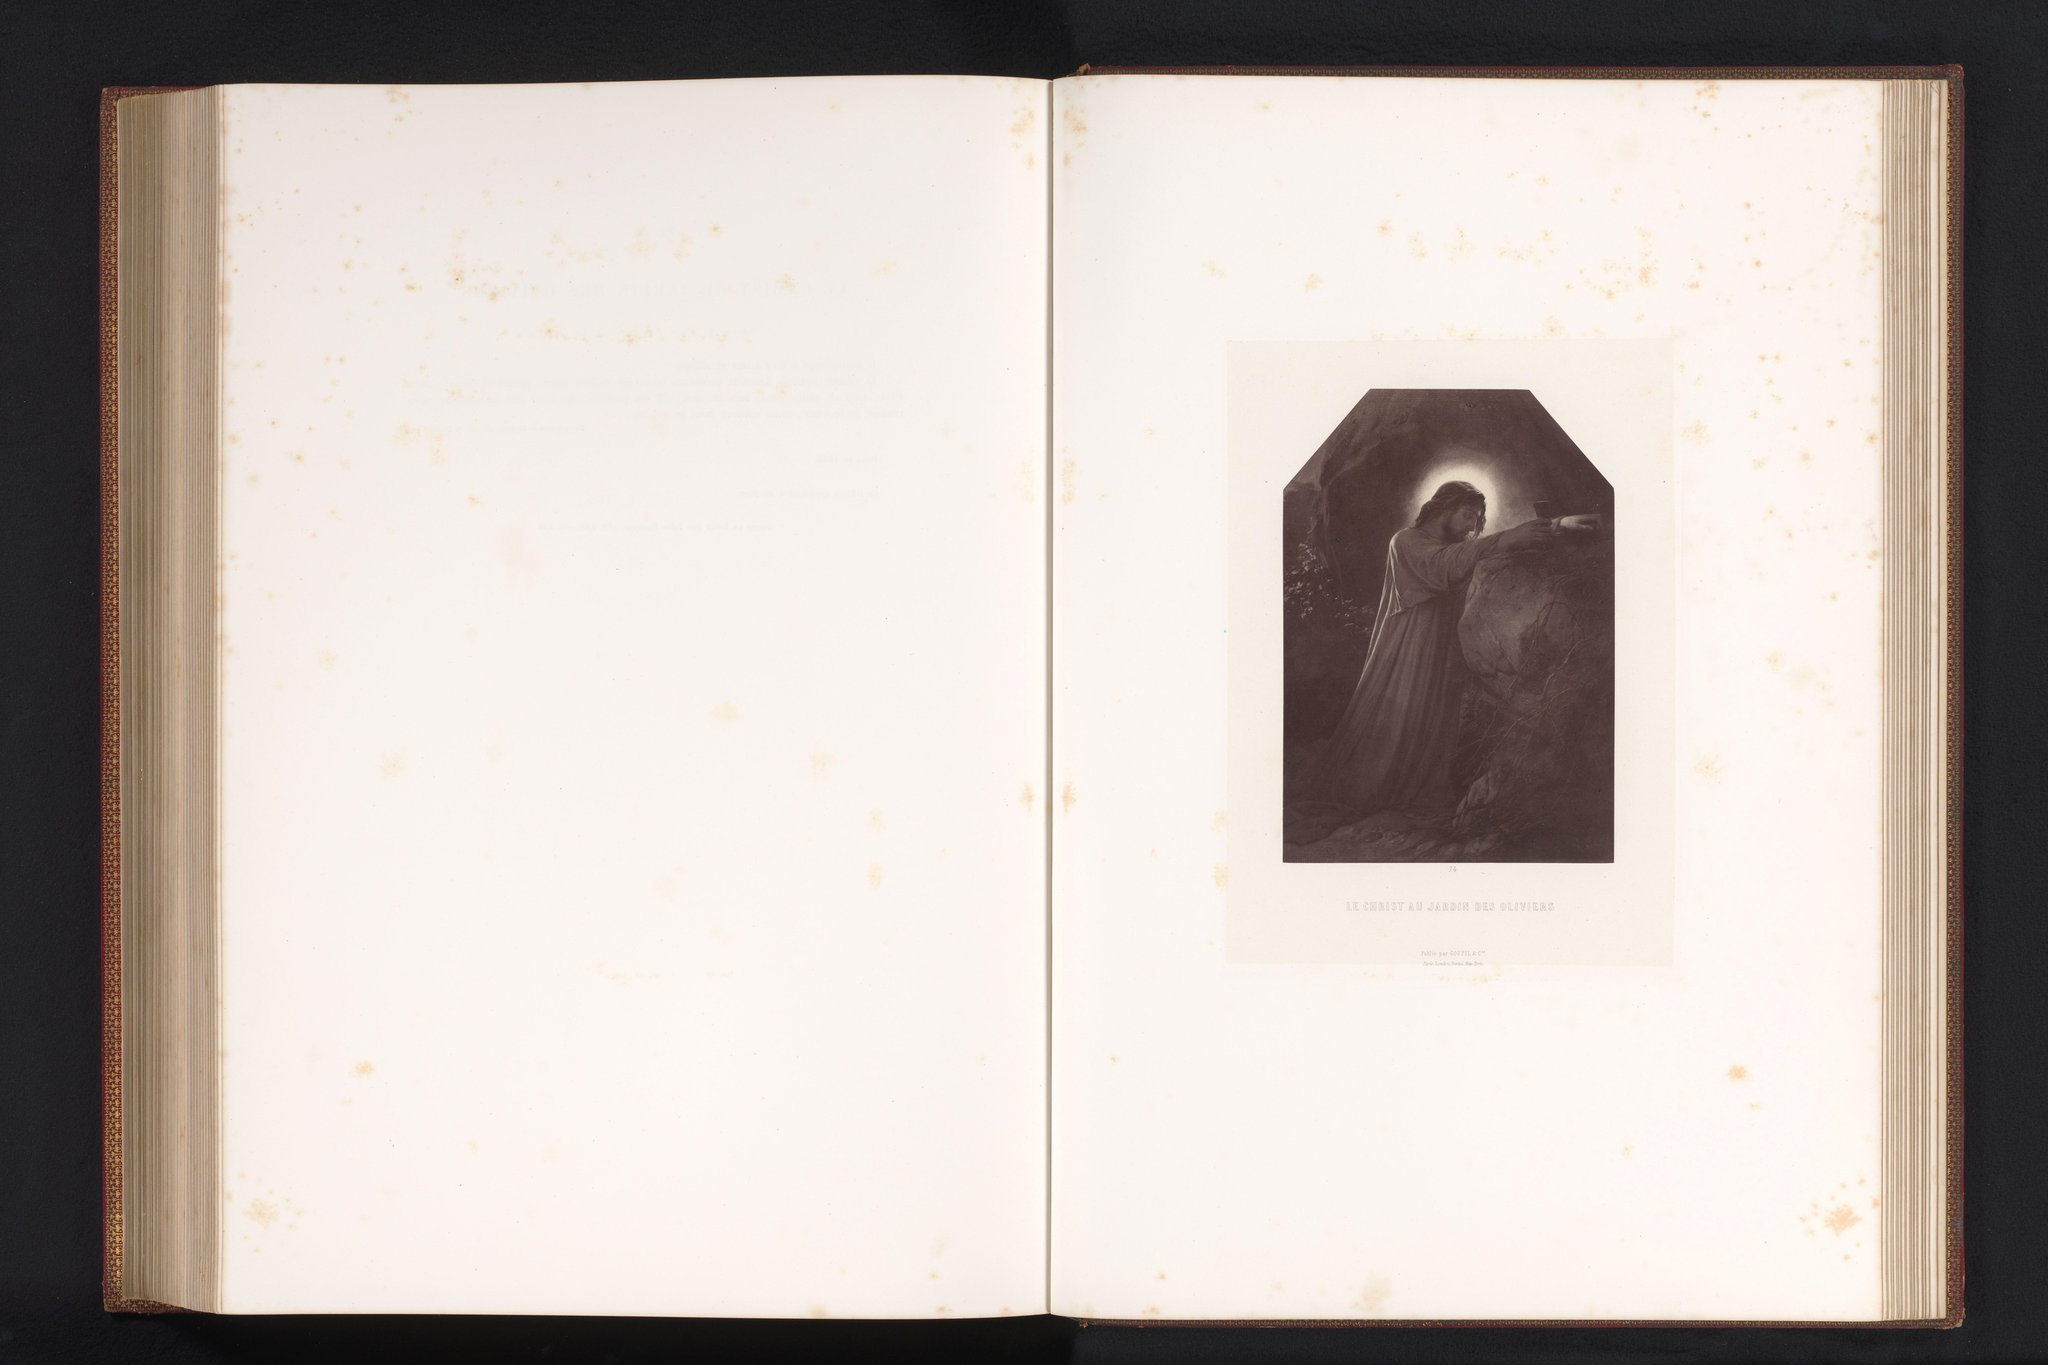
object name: reproduction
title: Le Christ au jardin des oliviers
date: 1855-1858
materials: paper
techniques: albumen print, engraving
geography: paris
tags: christ's prayer in the garden of gethsemane during the night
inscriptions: check stamp: ‘Goupil & Cie’